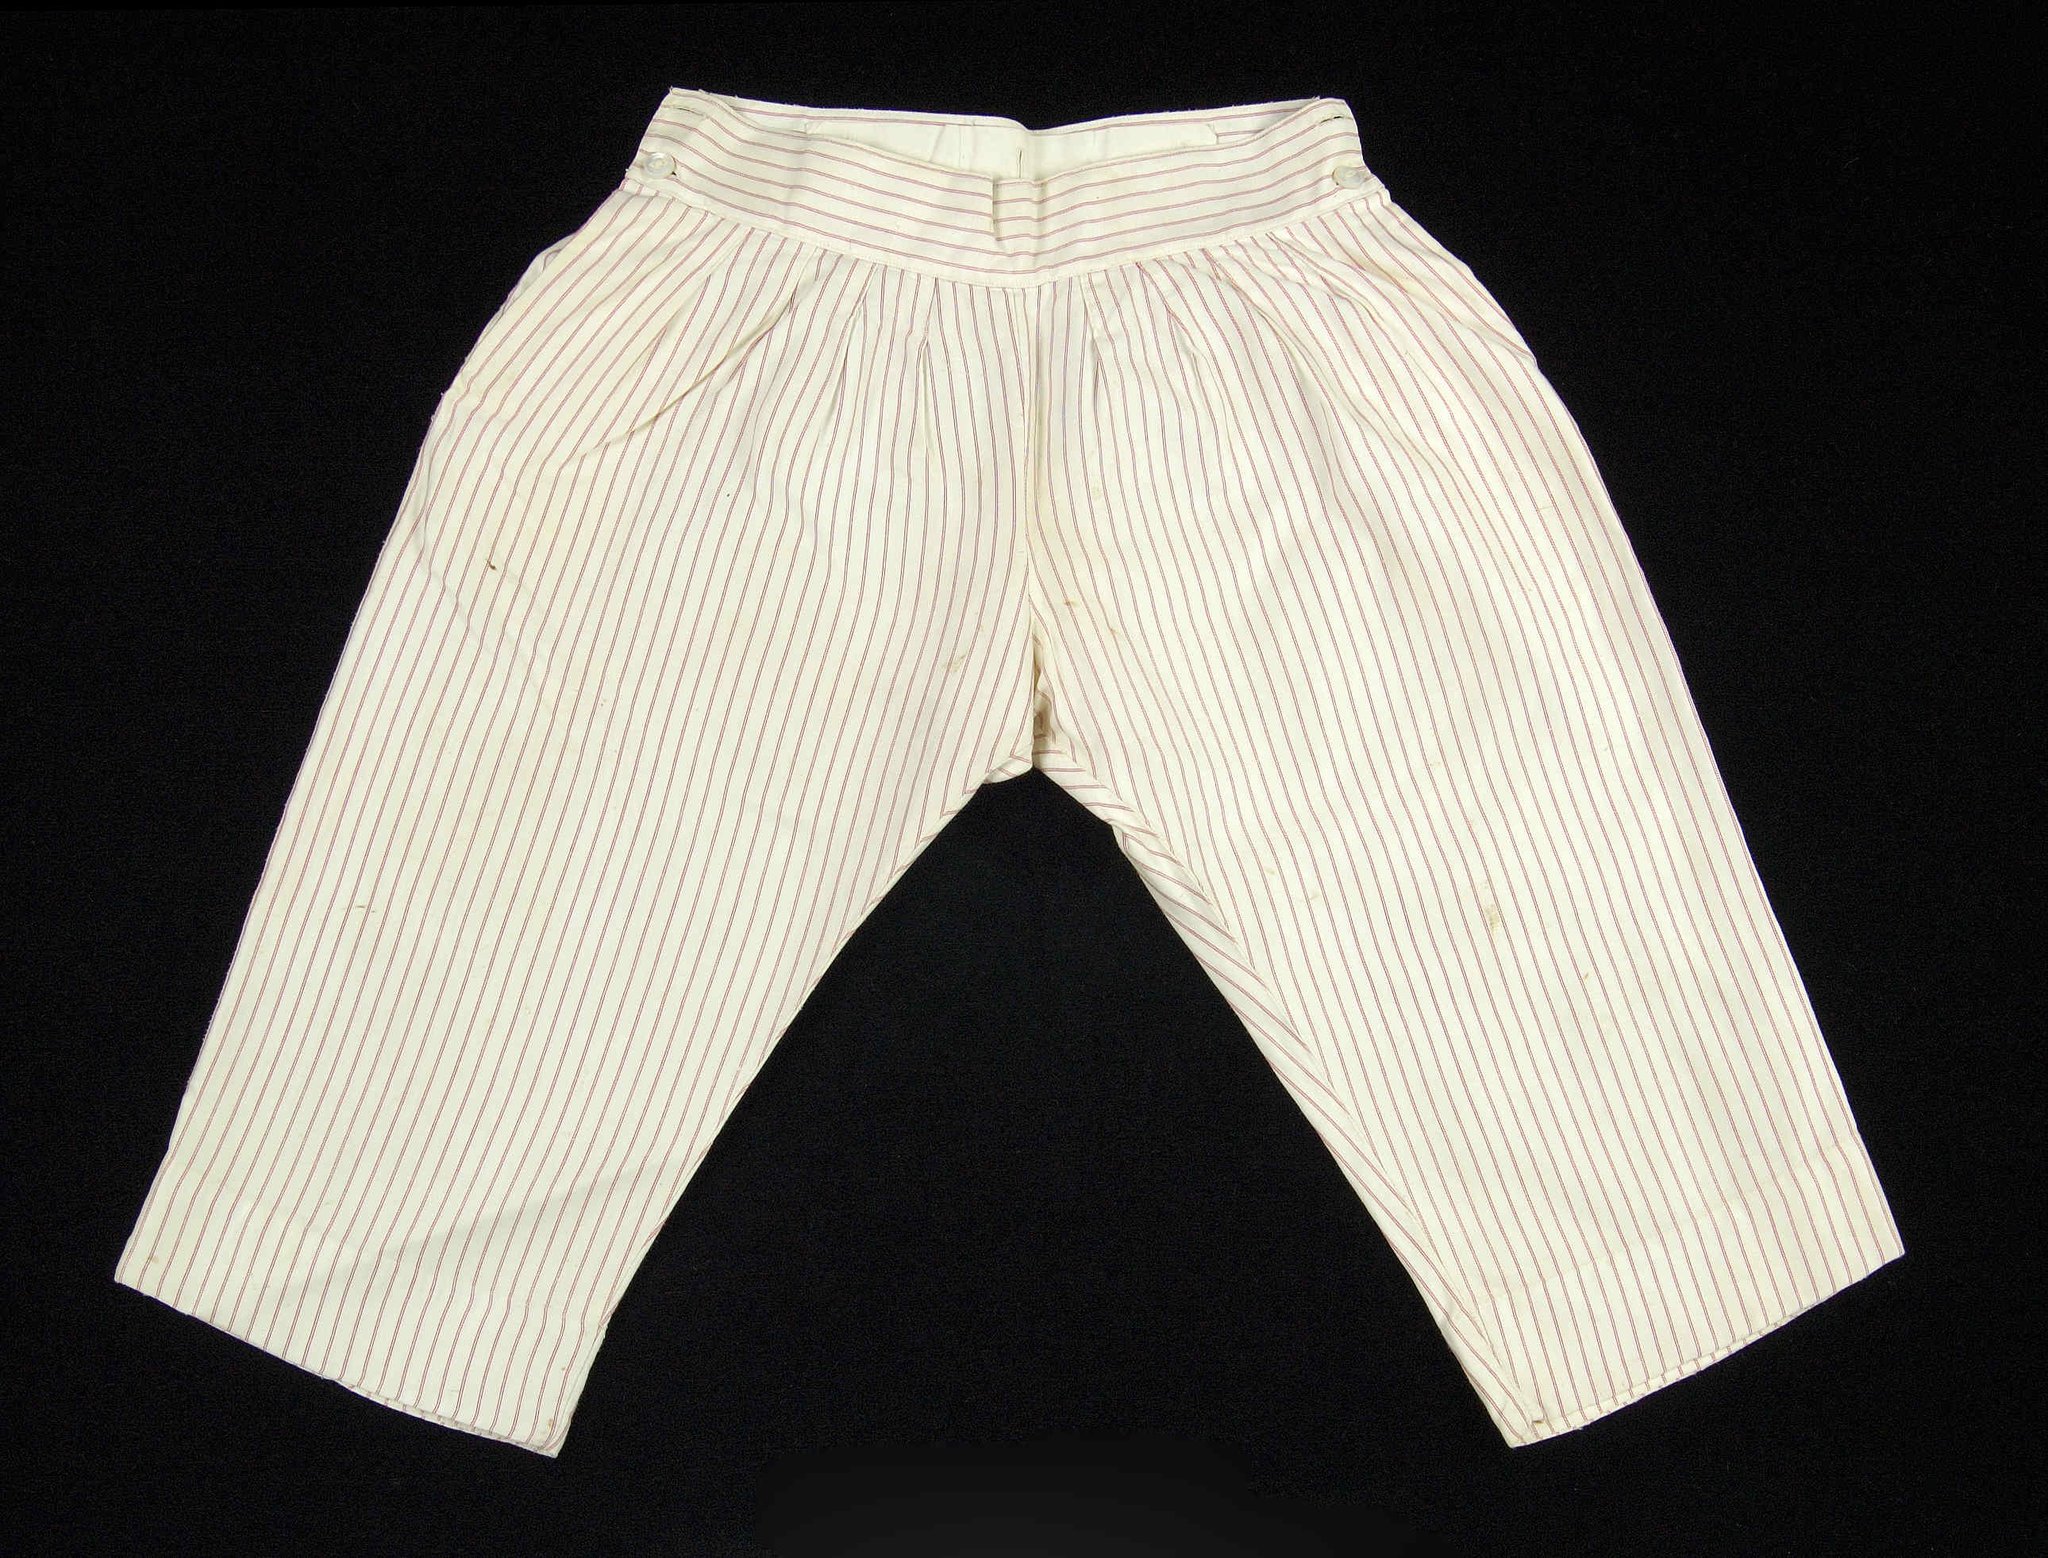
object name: trouser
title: Trousers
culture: american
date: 1840-1860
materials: cotton